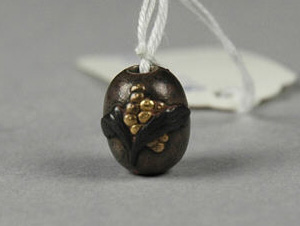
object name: ojime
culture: japanese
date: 1801-1900